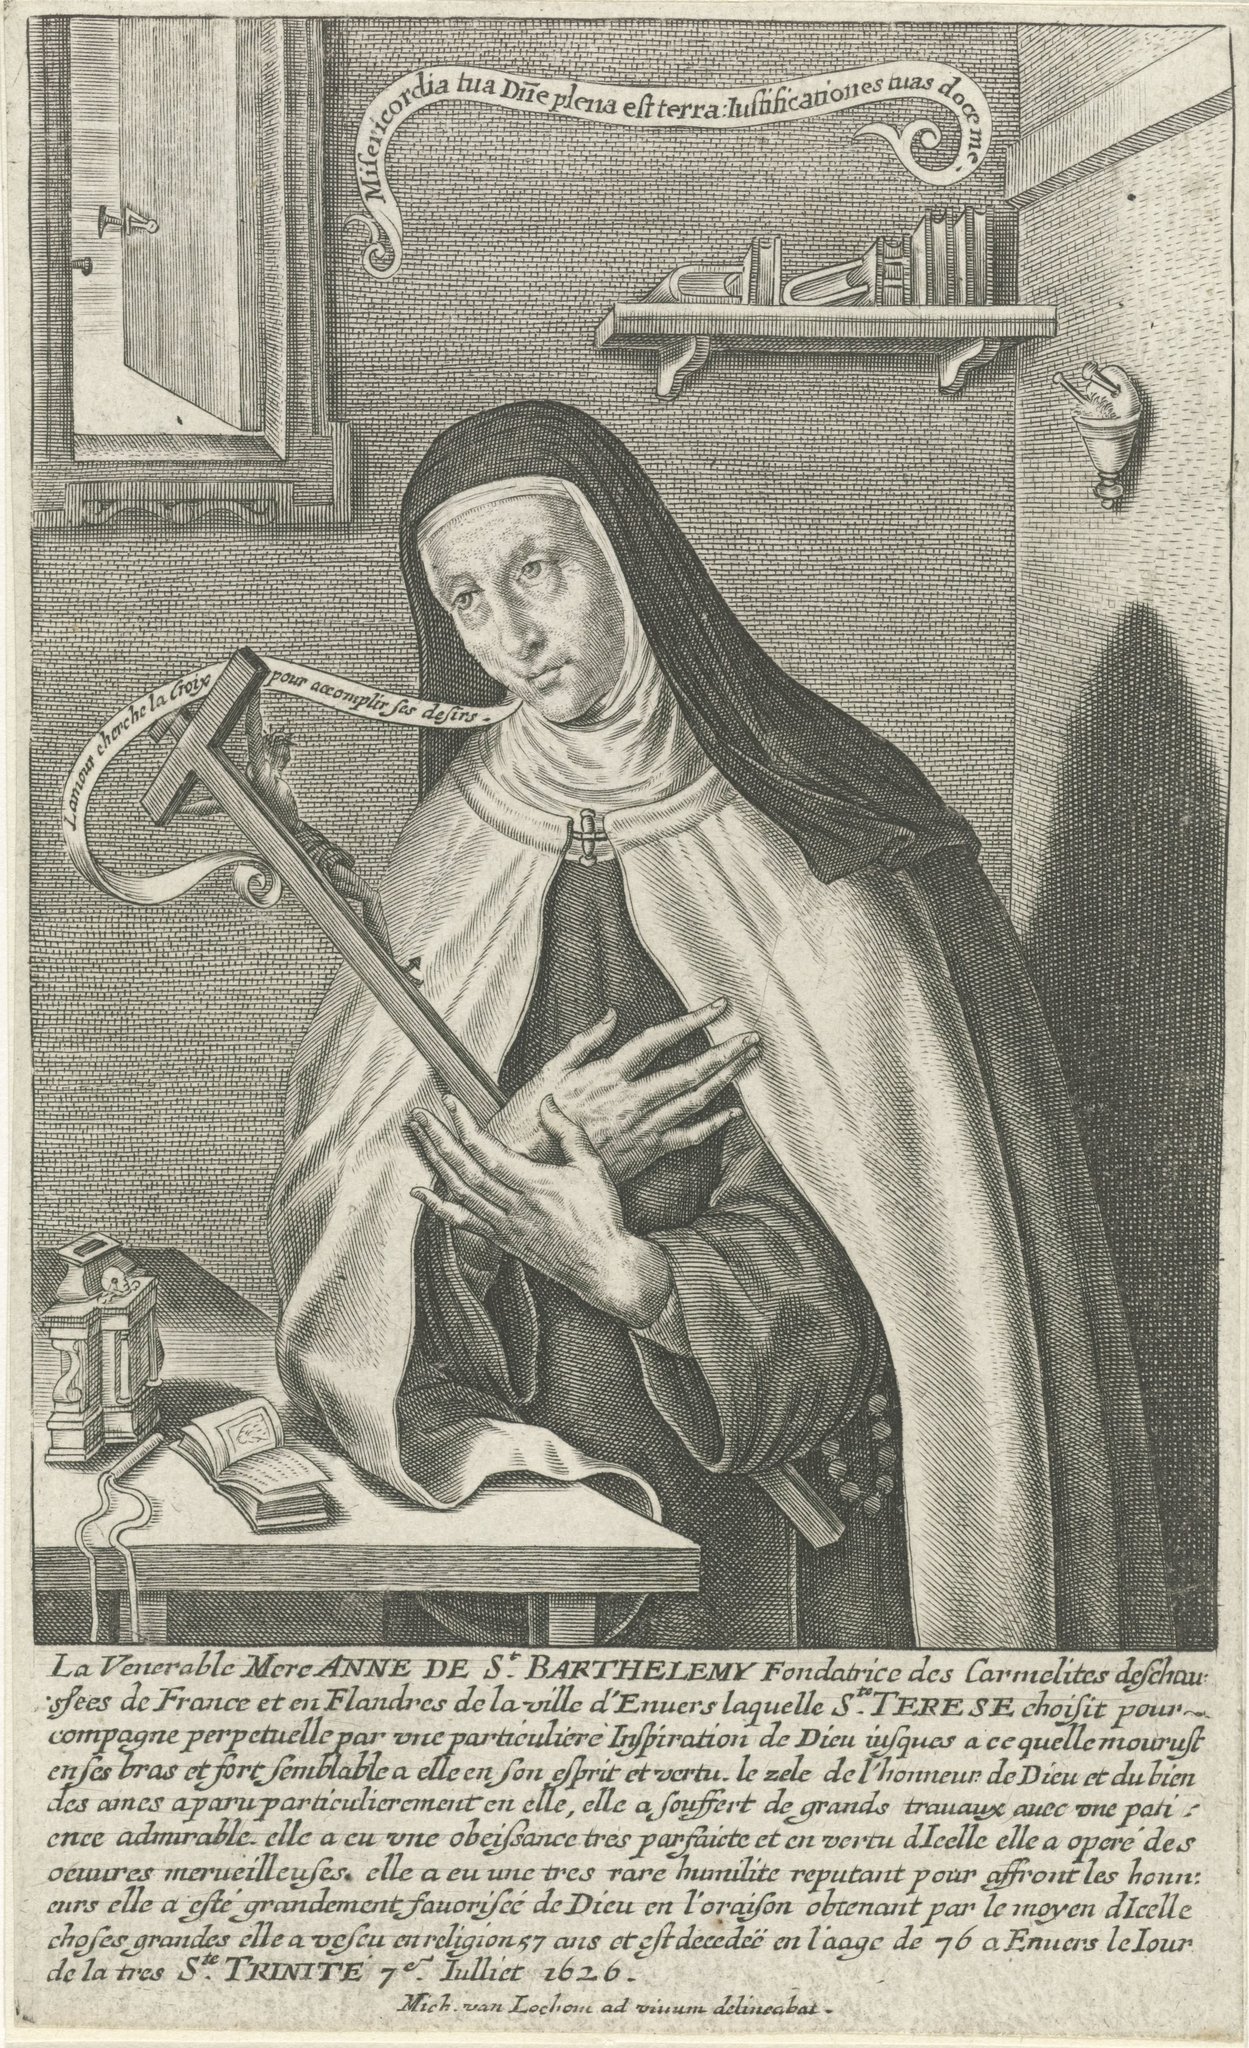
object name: print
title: Anna van de H. Bartholomeus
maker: michel van lochom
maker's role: print maker, publisher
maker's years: 1601-1647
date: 1611-1647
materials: paper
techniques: engraving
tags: altarcross, crucifix, monastic orders, monastic life ~ roman catholic church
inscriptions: collector's mark: Lugt 2228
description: De karmelietes Anna van de heilige Bartholomeus met een crucifix in haar handen.